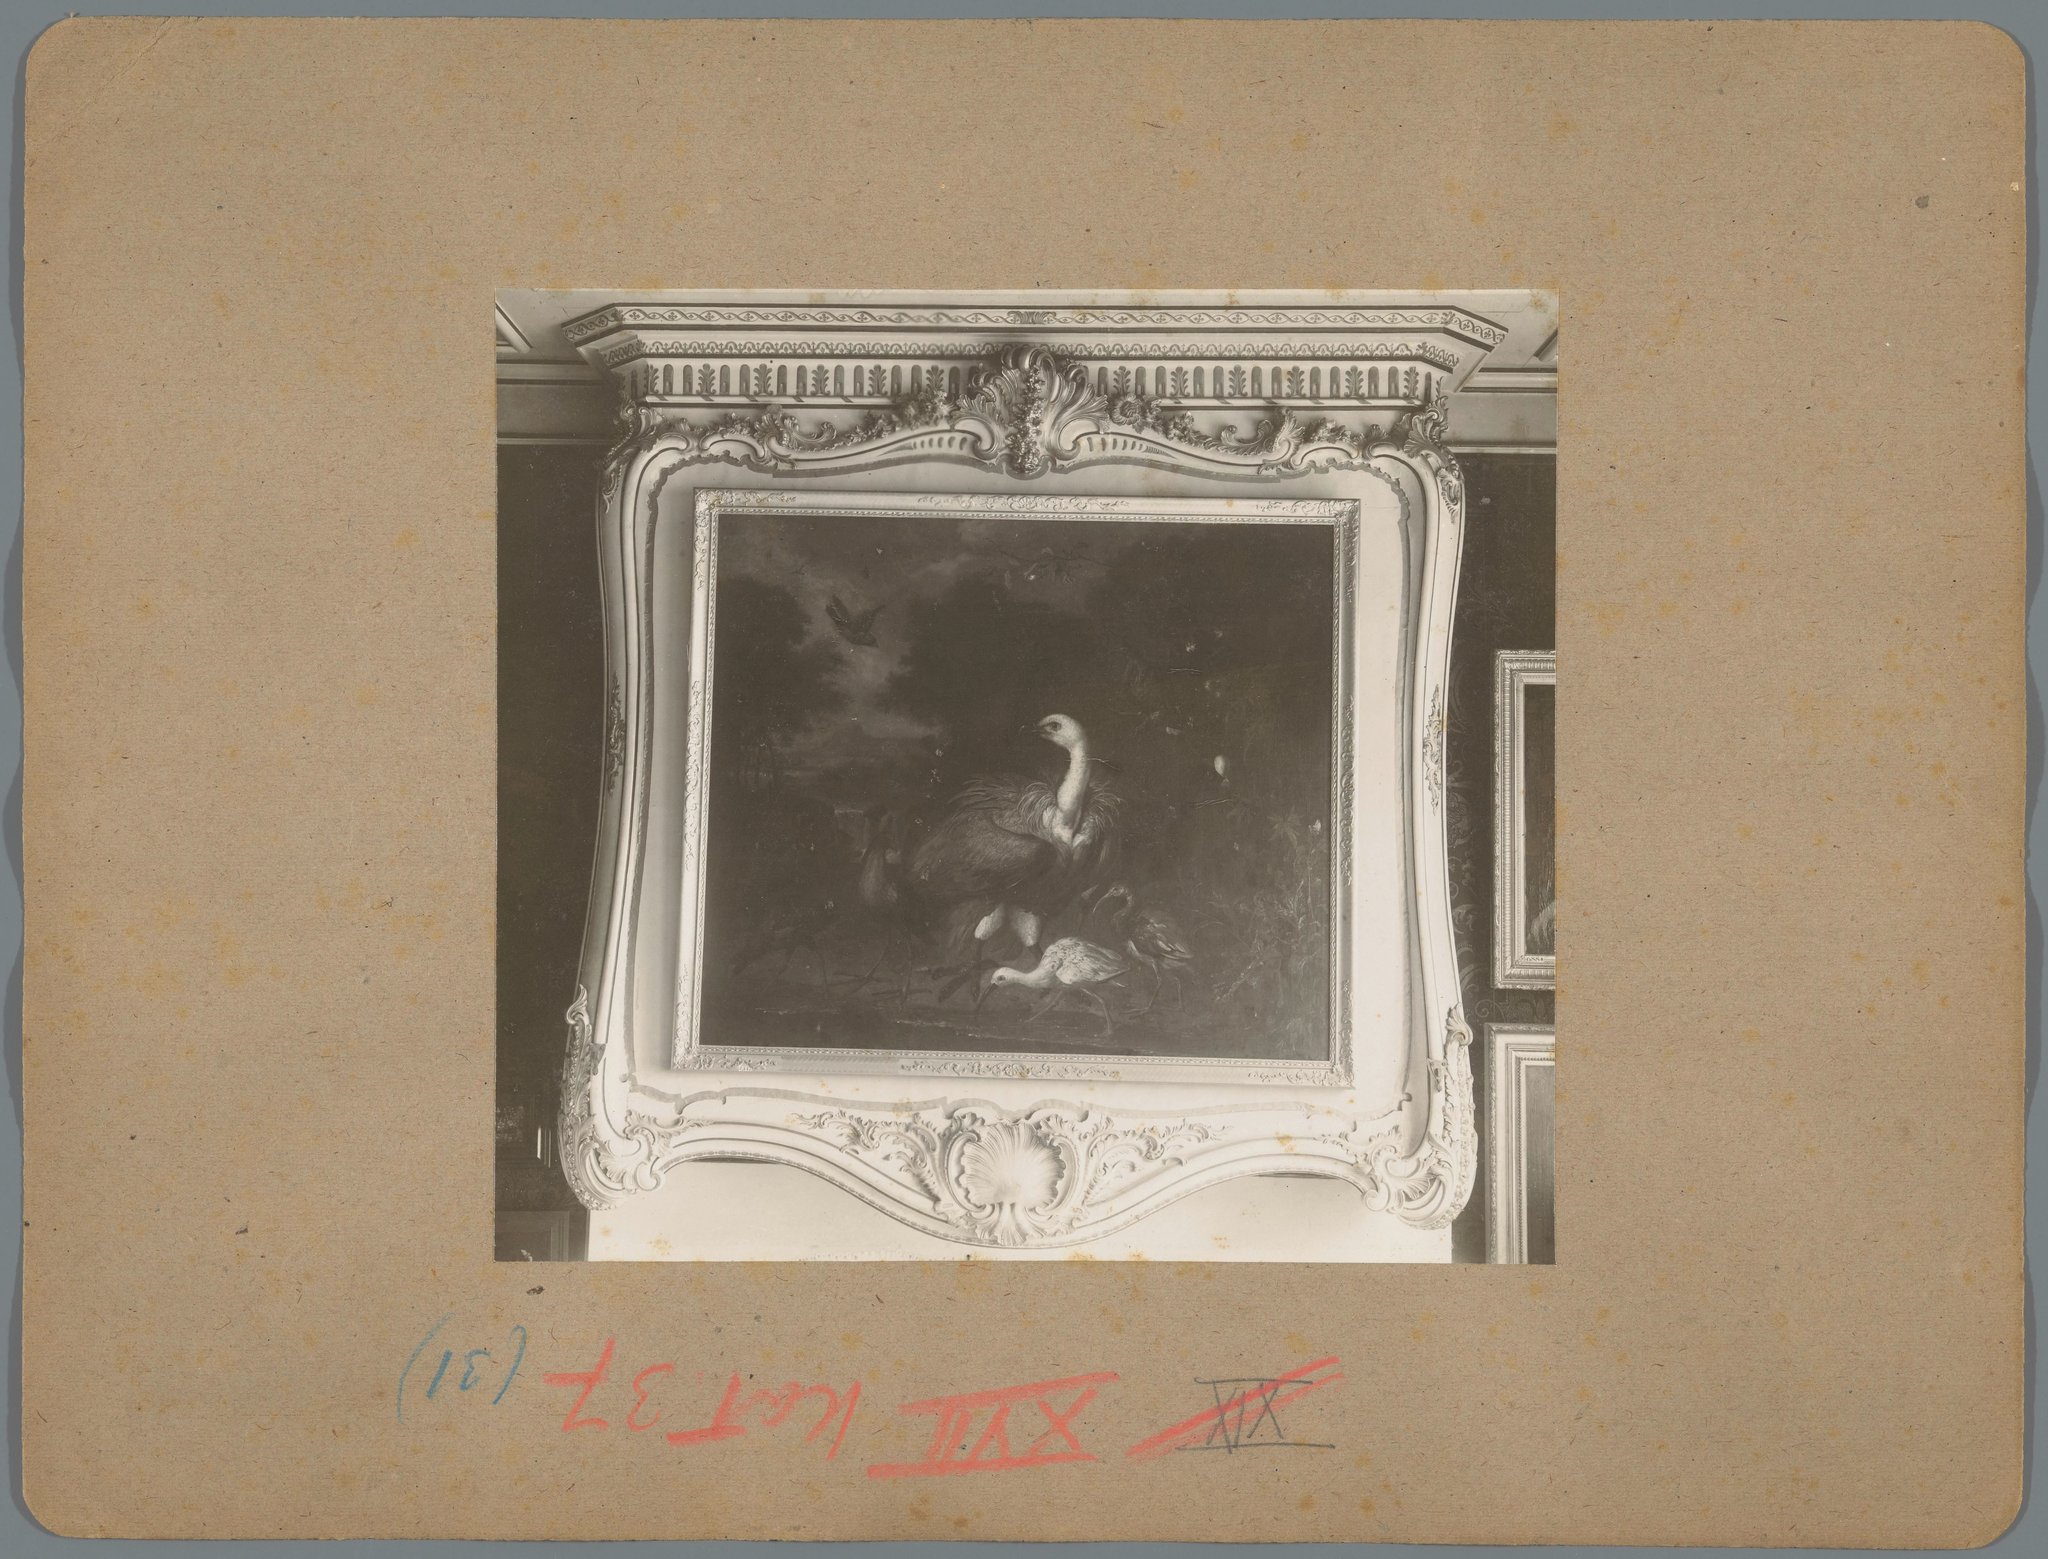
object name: photograph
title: Schoorsteenmantel met kroonlijst en schildering van vogels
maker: Anonymous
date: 1875-1900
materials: cardboard, photographic support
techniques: gelatin silver print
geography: europe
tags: birds, open hearth, fire-place, predatory birds: vulture, europe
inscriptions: collector's mark: ‘KUNSTNIJVERHEIDSCHOOL QUELLINUS AMSTERDAM FRANS HALSSTRAAT 14.’, number: ‘XVII’, collector's mark: ‘INSTITUUT VOOR KUNST-NIJVERHEIDSONDERWIJS GABRIËL METSUSTRAAT No. 16 AMSTERDAM’, number: ‘(31)’, number: ‘Kat 37’